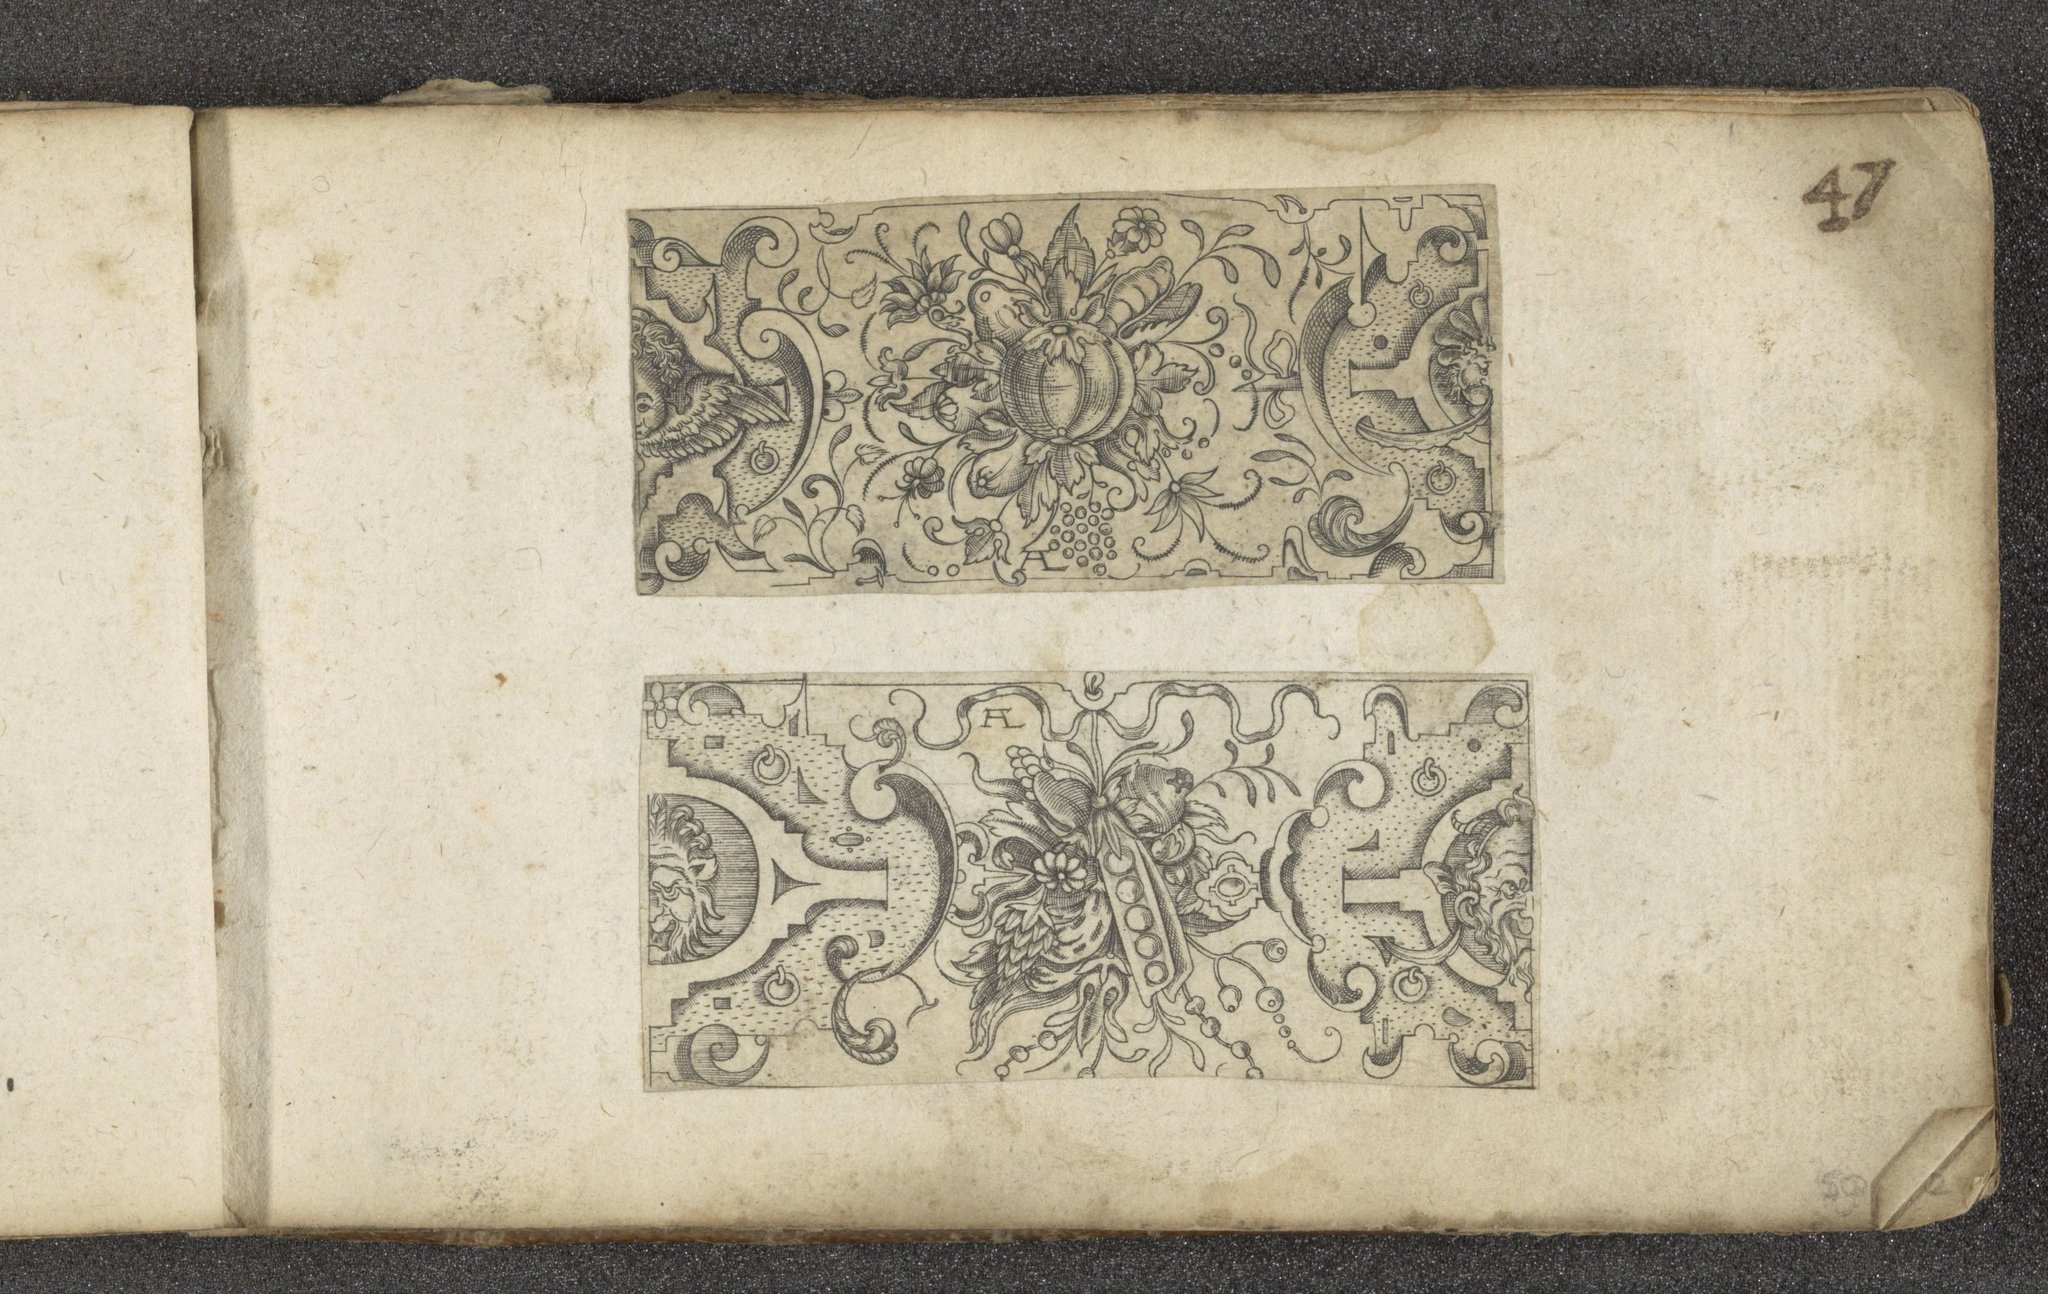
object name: album leaf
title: Randdecoratie met vruchtentros en peul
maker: andreas luining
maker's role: publisher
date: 1589-1593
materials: paper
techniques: engraving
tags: ornaments ~ art, fruits and vegetables ~ ornament, ornament ~ cartouche, mask, mascaron ~ ornament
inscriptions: inscription: ‘47’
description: Randdecoratie met vruchtentros. Aan de tros hangt ook een peul. Geflankeerd door twee halve cartouches met een mascaron. De prent maakt deel uit van een album.